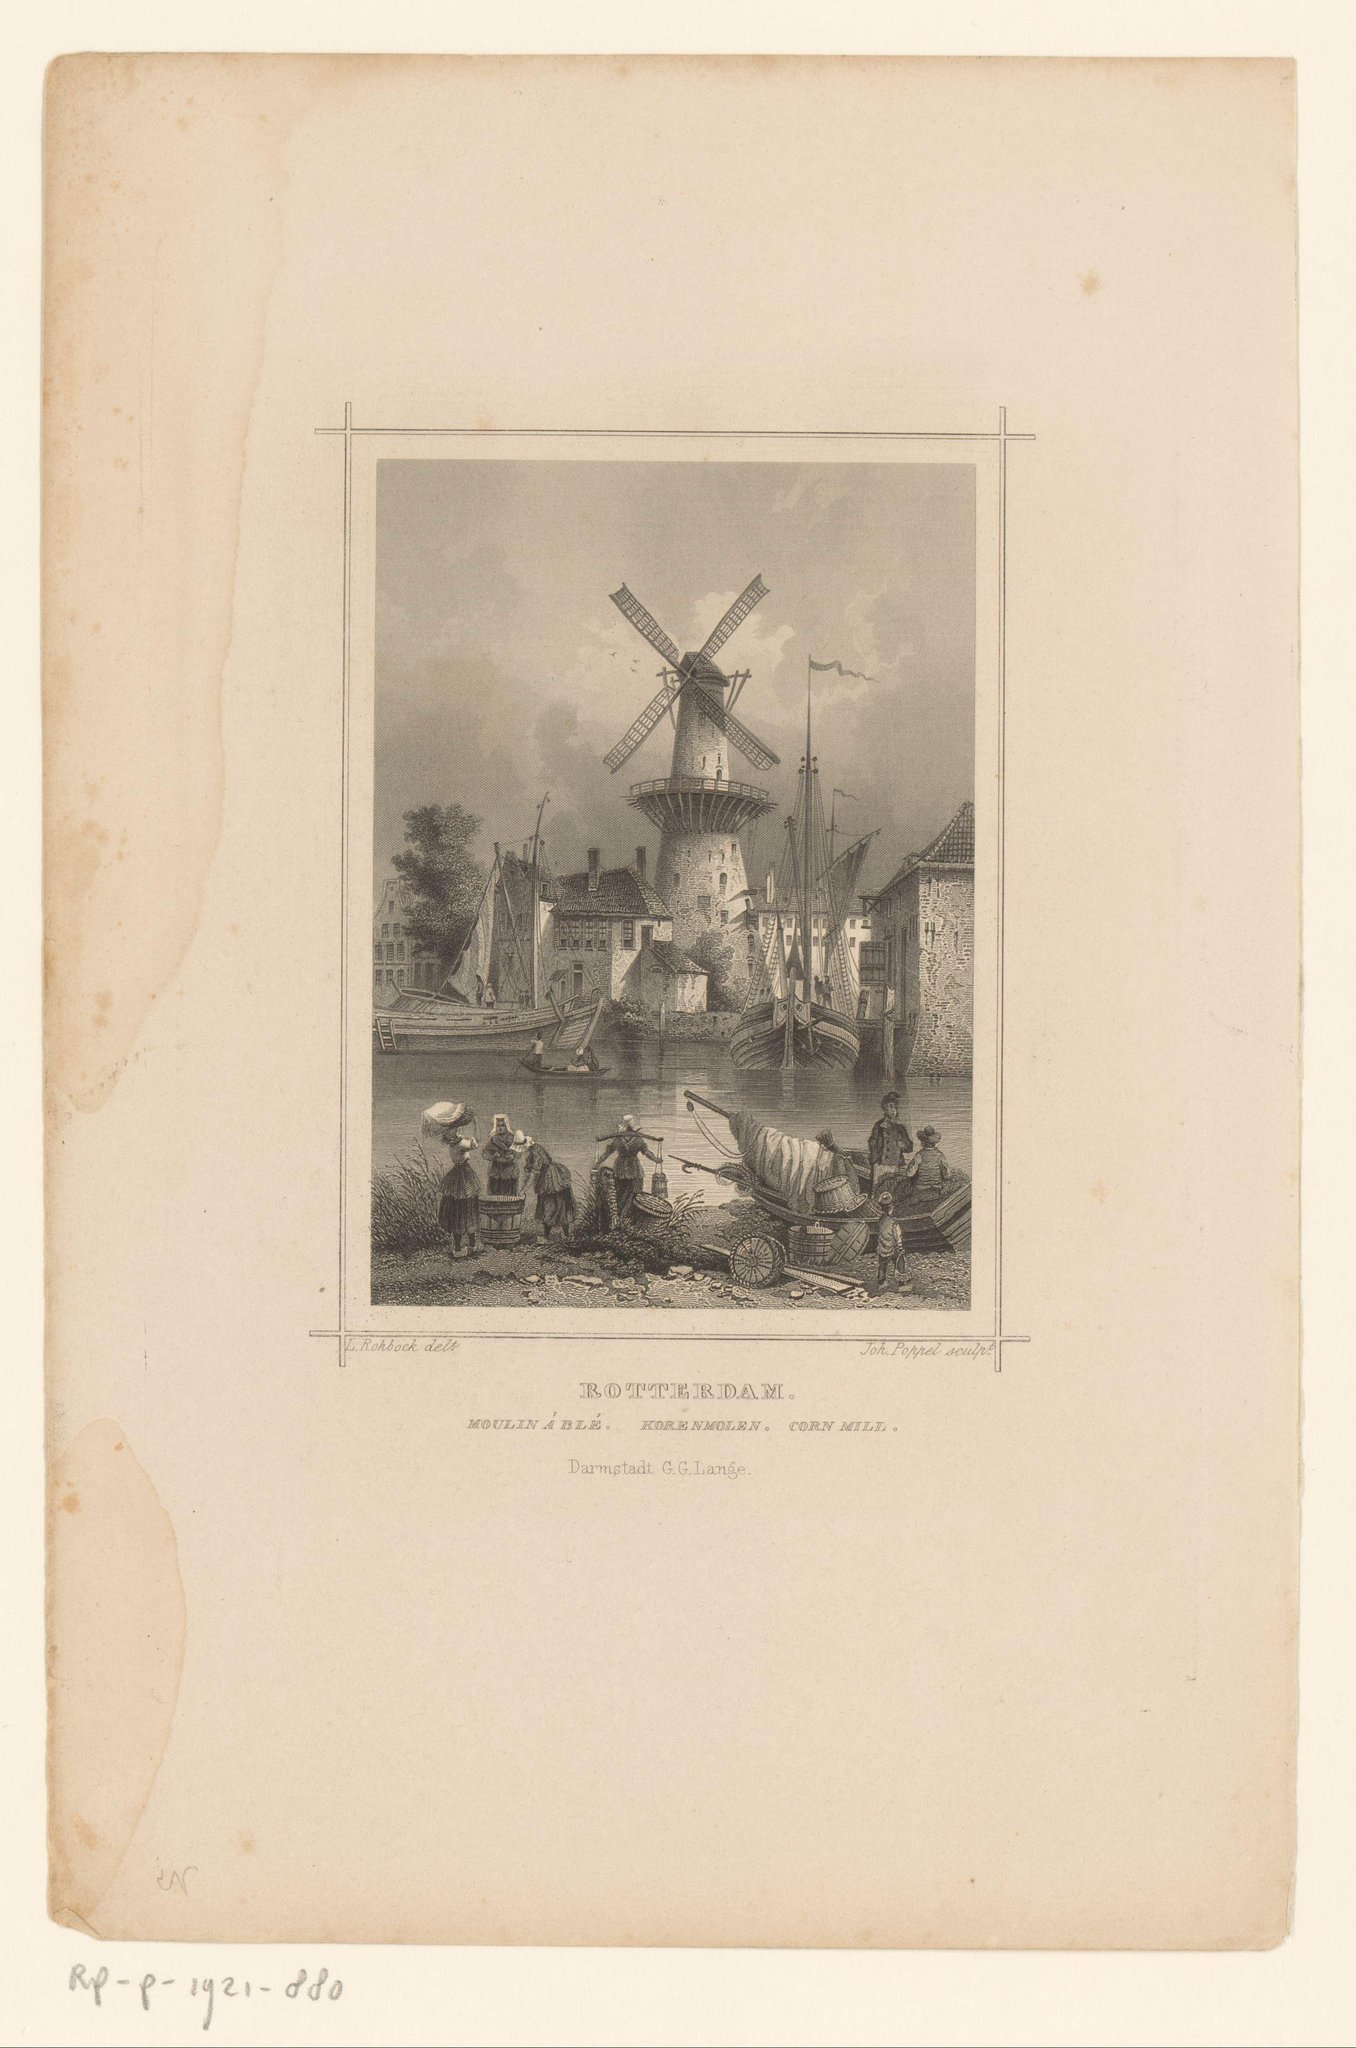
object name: print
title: Gezicht op de Distilleerketel in Delfshaven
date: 1858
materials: paper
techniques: engraving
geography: darmstadt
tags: city-view, and landscape with man-made constructions, windmill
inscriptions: collector's mark: Lugt 2228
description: Prent ook gebruikt in: Terwen, Johannes Leonardus. Het Koningrijk der Nederlanden voorgesteld in eene reeks van naar de natuur geteekende schilderachtige gezigten. Gouda: Van Goor, 1858-1862.